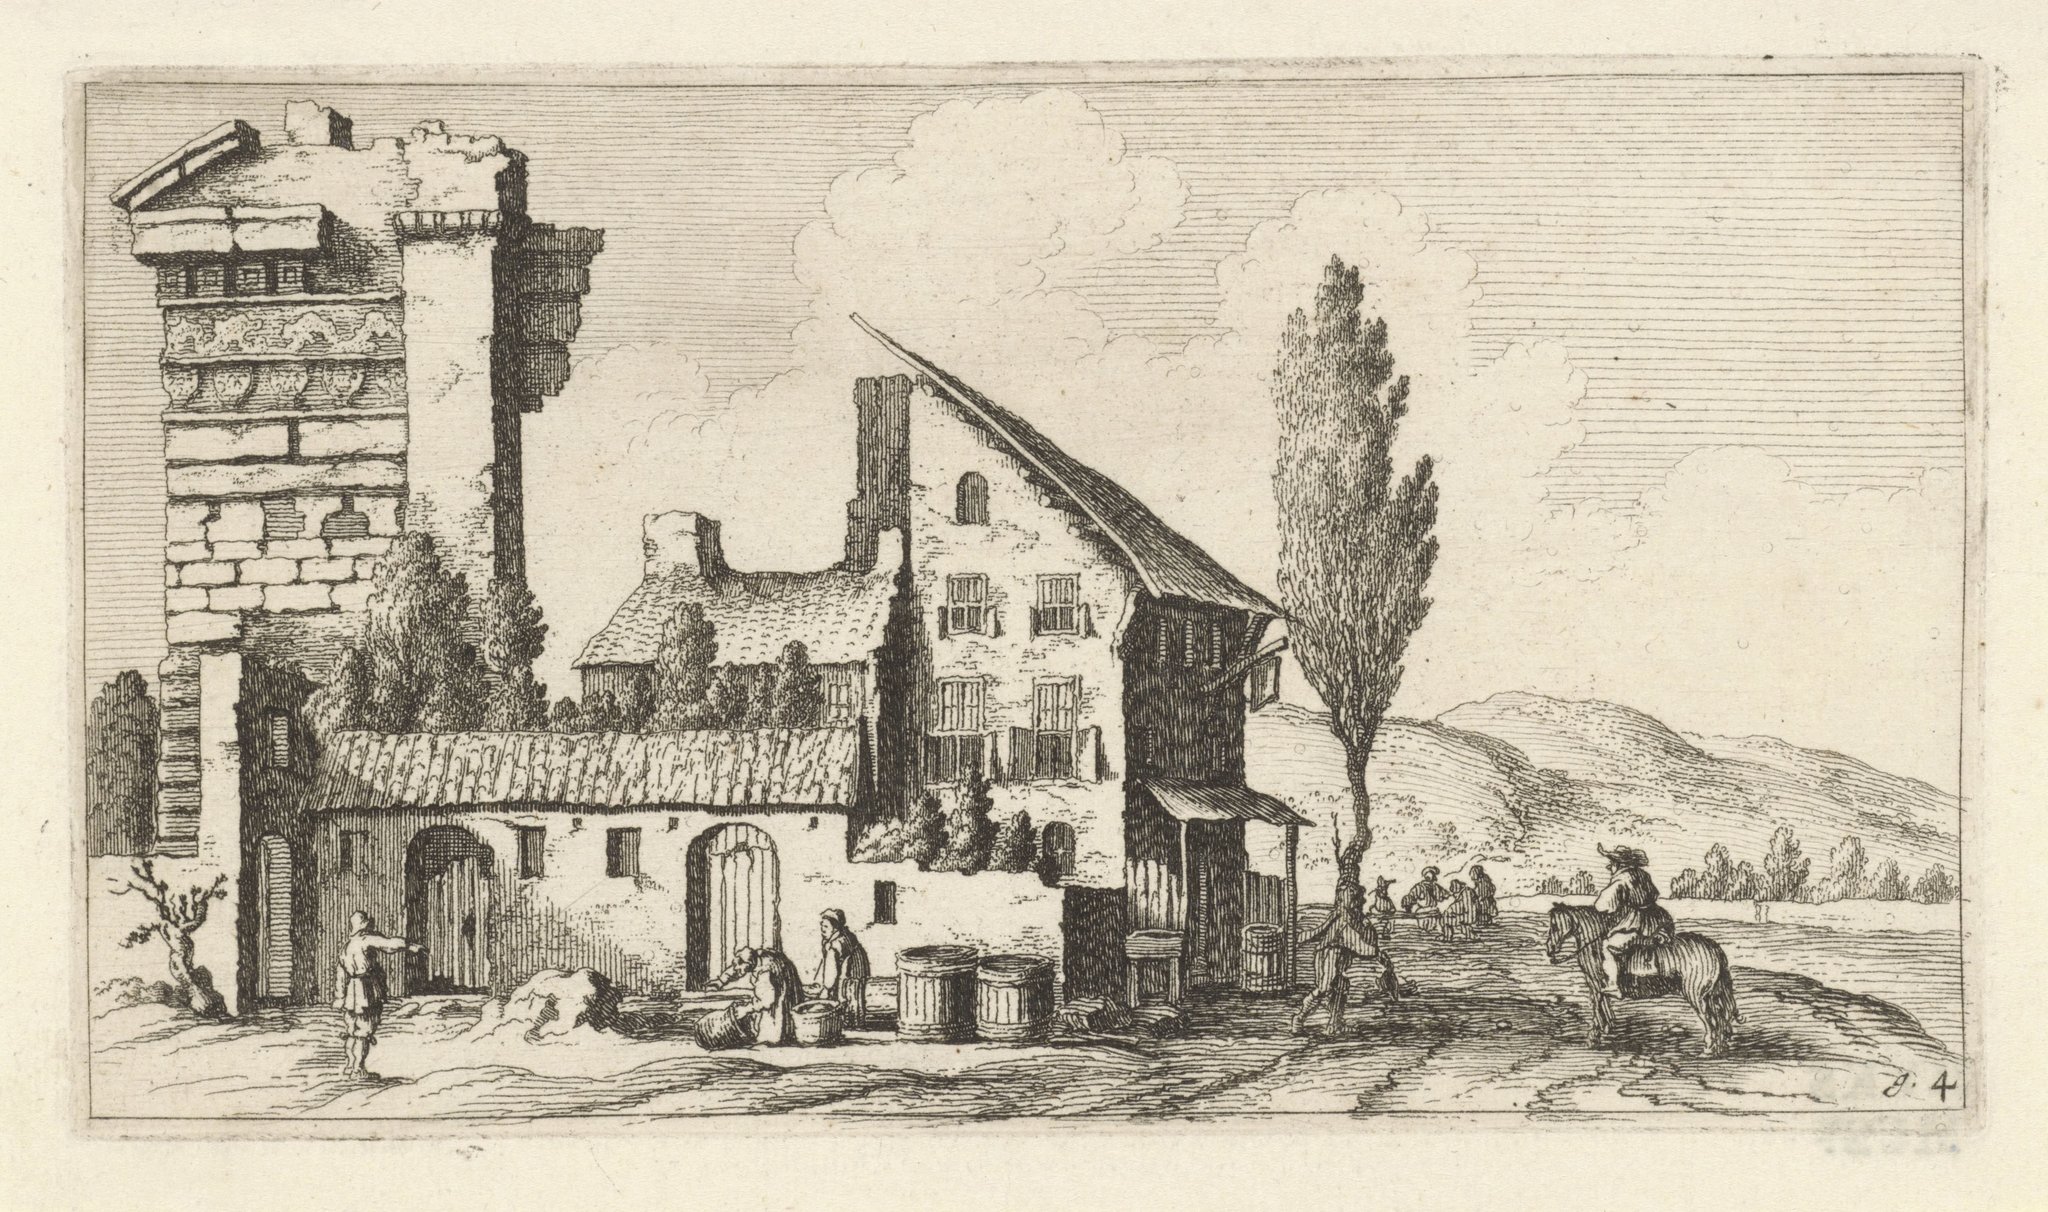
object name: print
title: Romeinse ruïne omgebouwd tot een boerderij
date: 1605-1653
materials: paper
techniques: etching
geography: amsterdam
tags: riding a horse, ass, or mule; rider, horseman, farm or solitary house in landscape, ruin of a dwelling, house, castle, etc.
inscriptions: collector's mark: Lugt 2165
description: In een glooiend landschap ligt een tot een boerderij omgebouwde Romeinse ruïne. Bij de boerderij verschillende figuren en een ruiter. De prent maakt deel uit van een serie van twaalf landschappen.